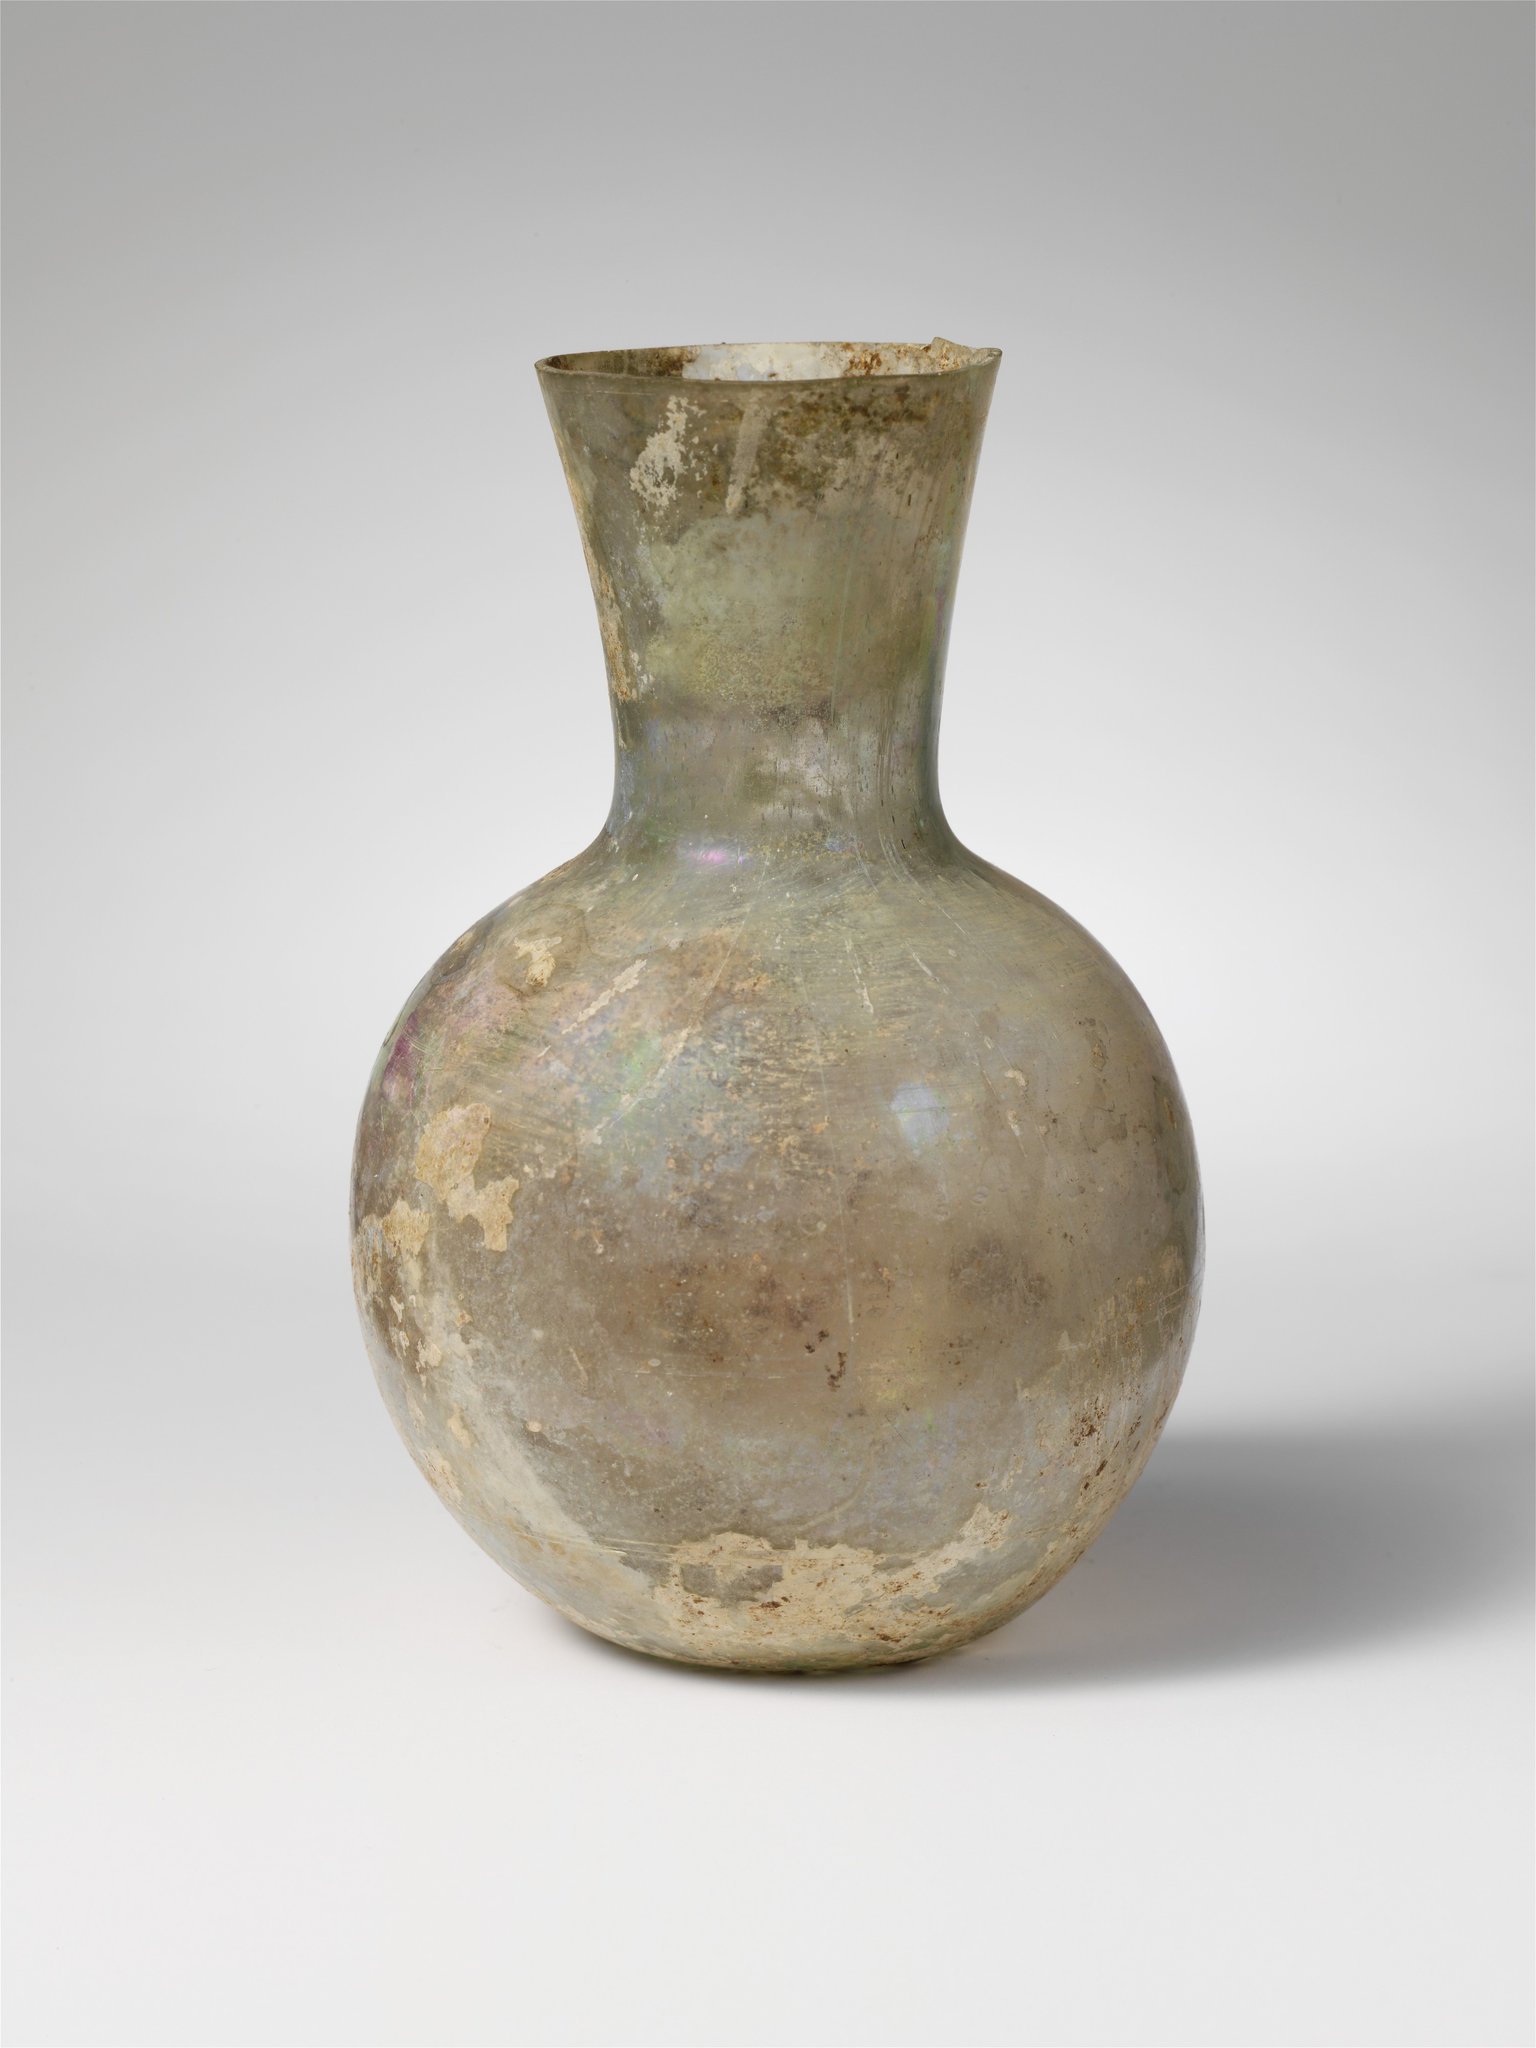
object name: flask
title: Glass flask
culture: roman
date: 201-400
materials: glass